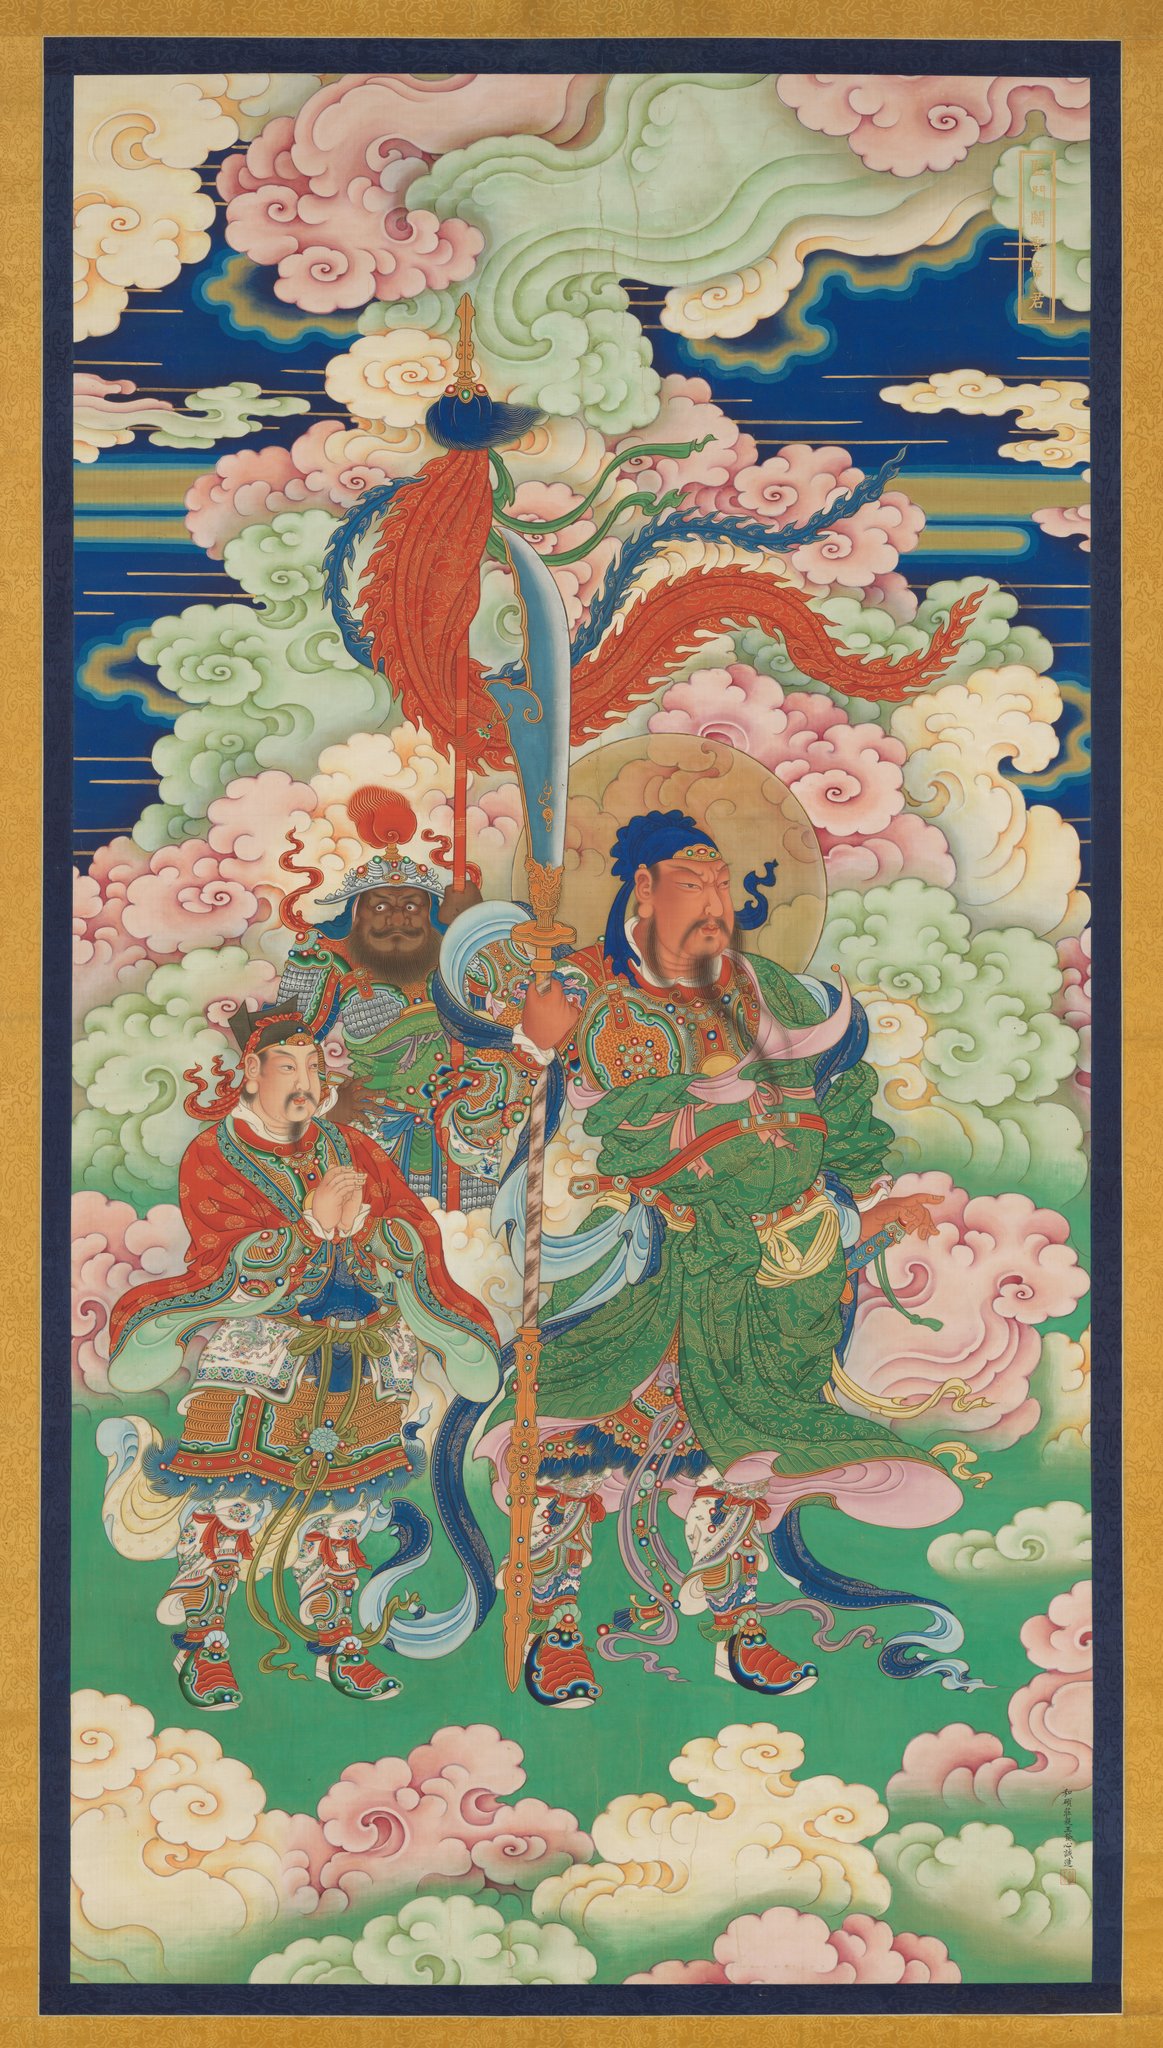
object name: hanging scroll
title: Guan Yu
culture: chinese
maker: unidentified artist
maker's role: artist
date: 1700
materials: gold, ink, silk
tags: men